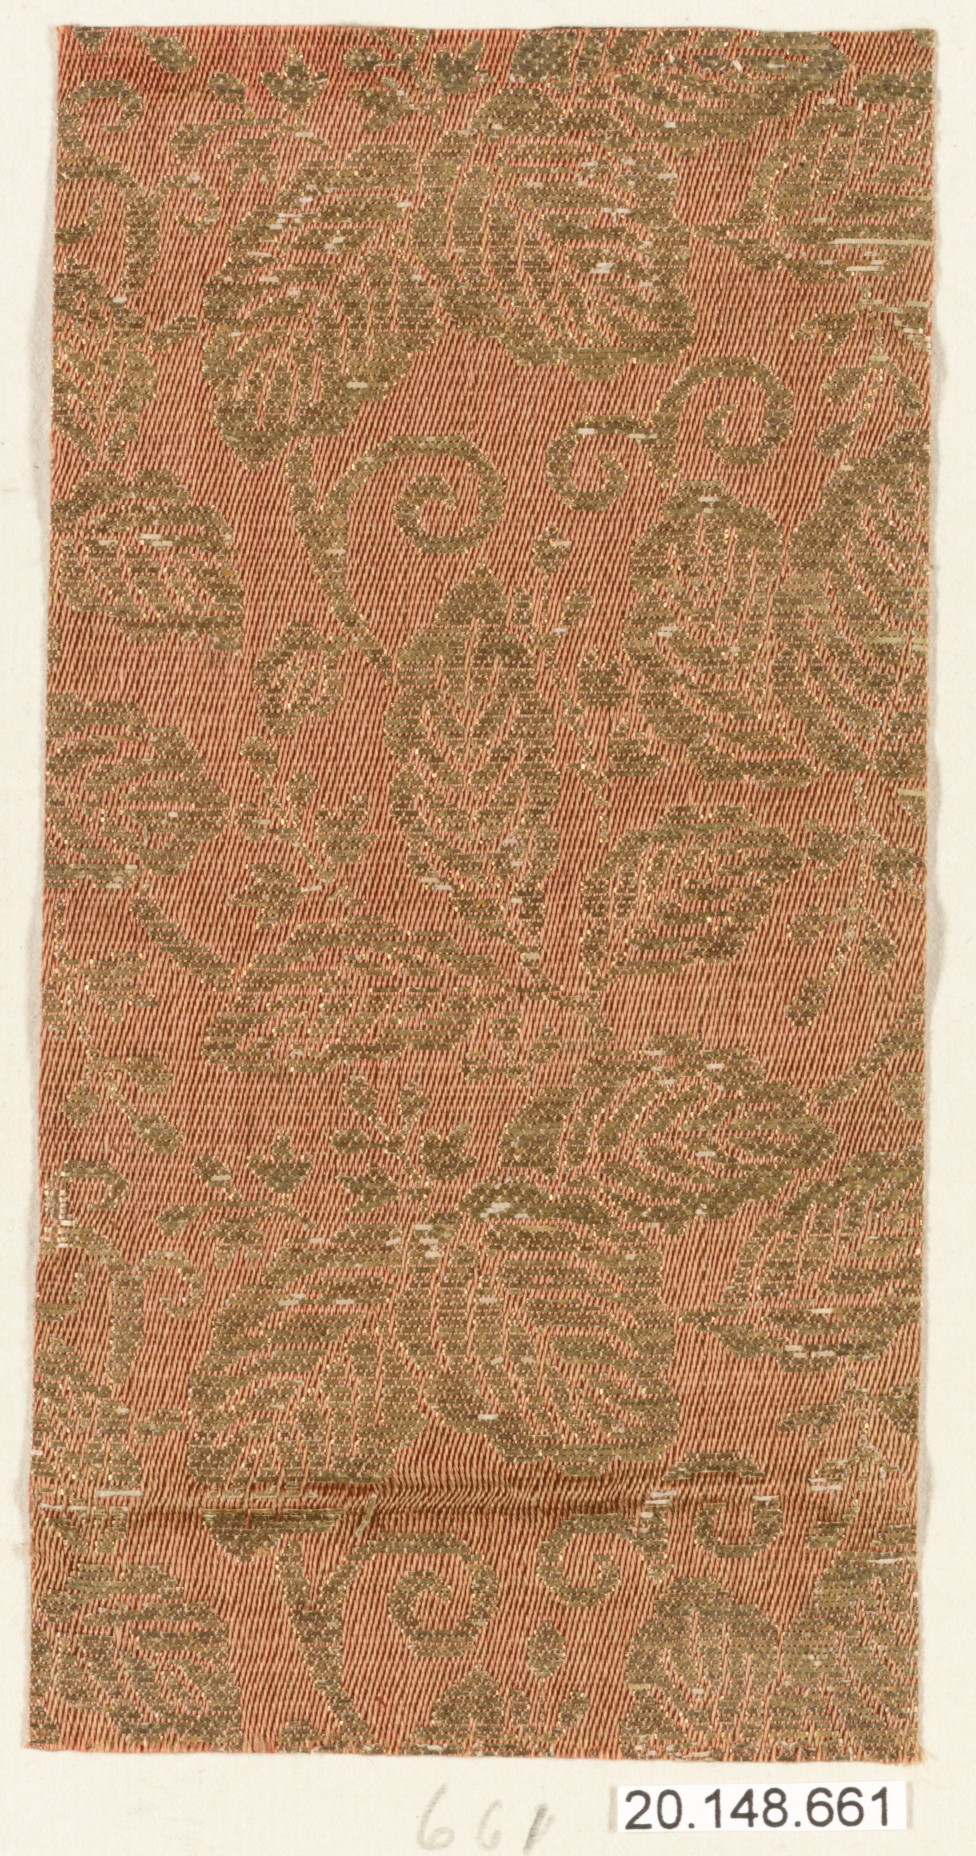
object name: piece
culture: japanese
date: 1601-1700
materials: silk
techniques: compound weave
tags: leaves